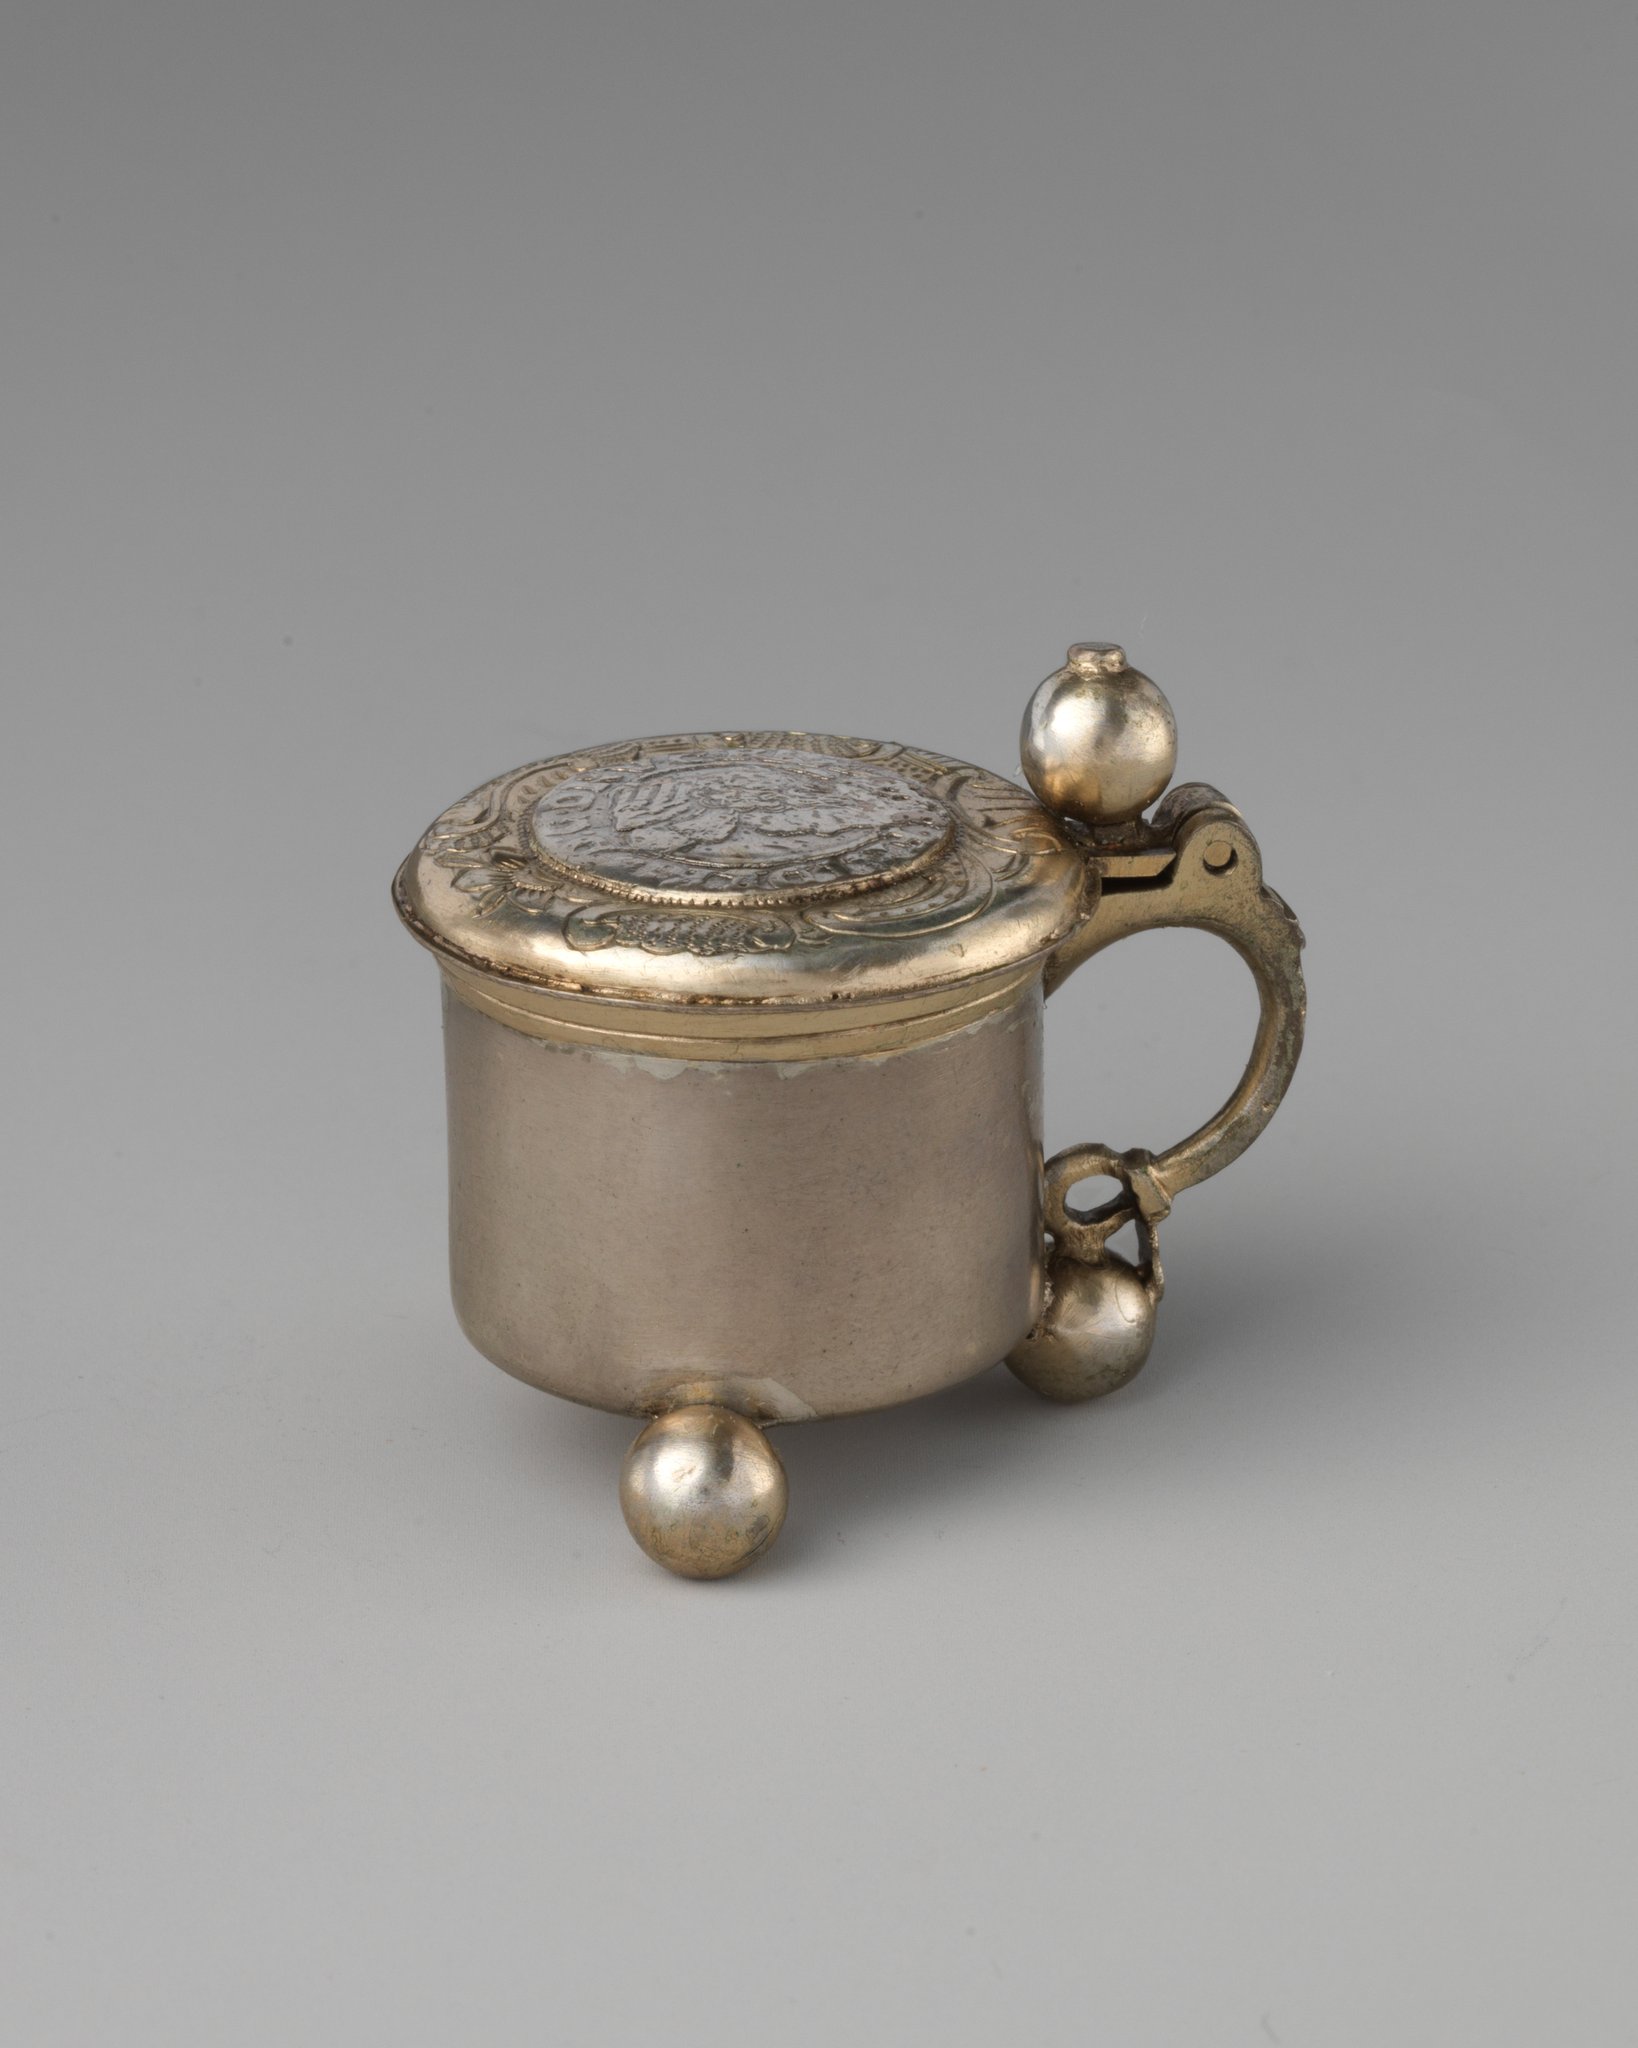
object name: tankard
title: Miniature tankard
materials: gilt, silver